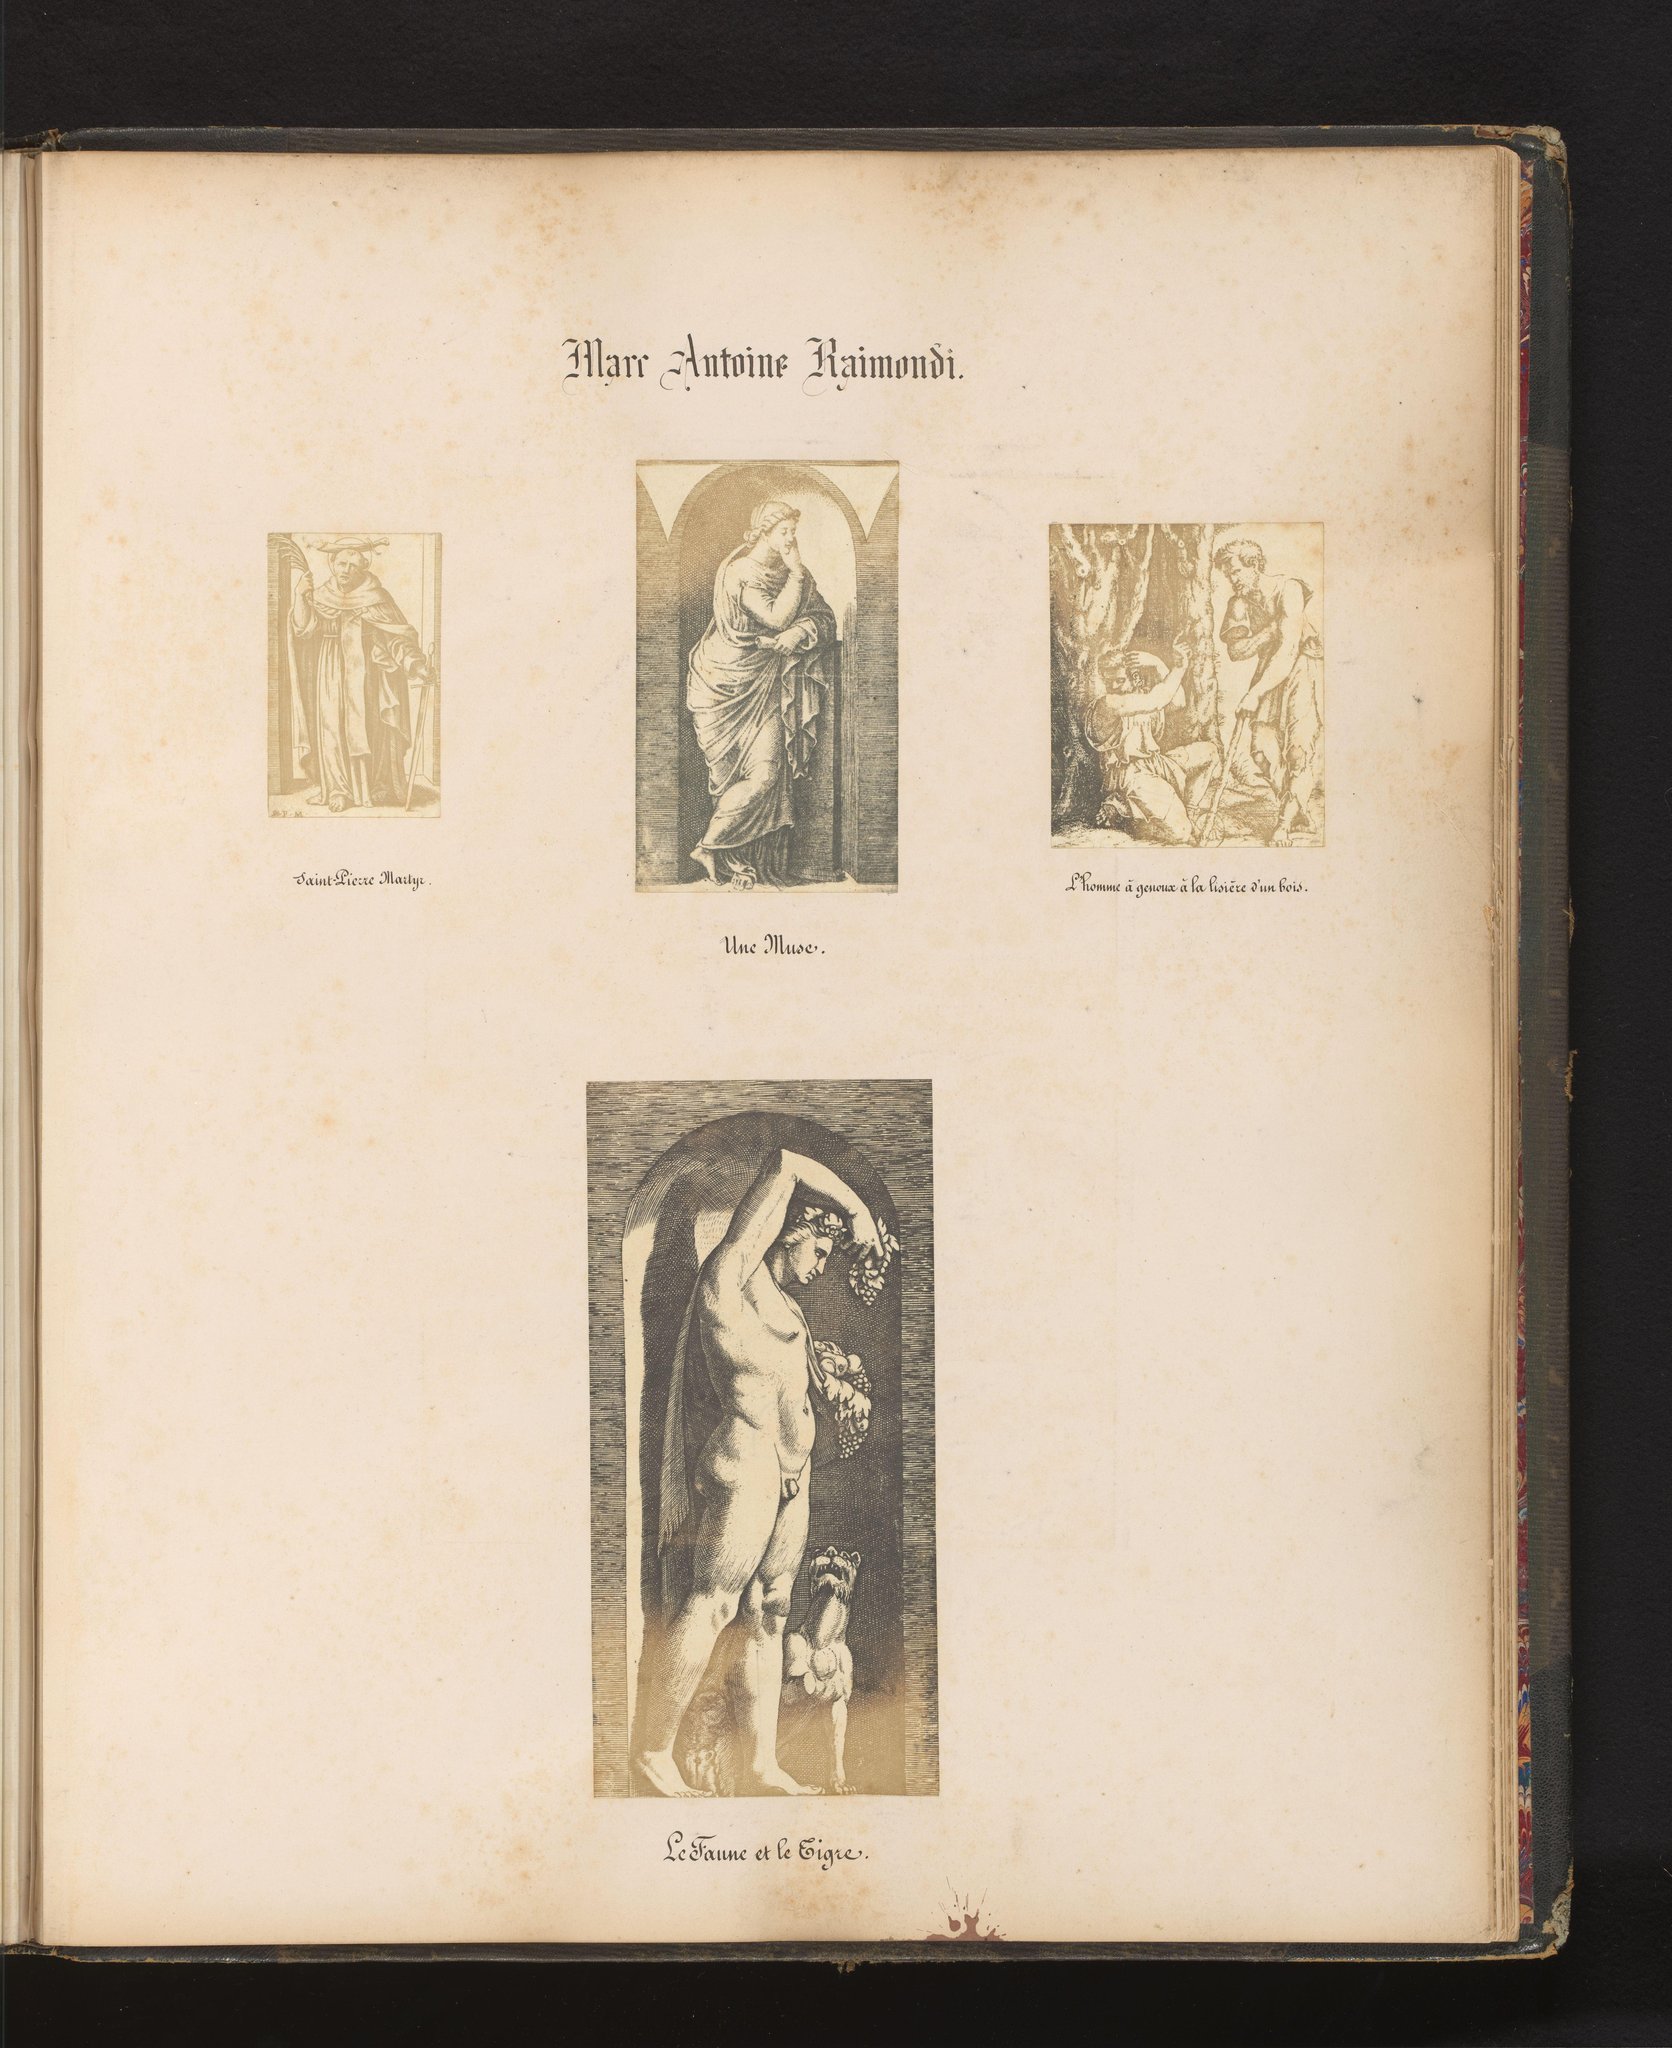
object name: photograph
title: Fotoreproductie van een gravure van een faun en een tijger door Marcantonio Raimondi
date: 1848-1853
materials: photographic support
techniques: salted paper print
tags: beasts of prey, predatory animals: tiger, satyrs, fauns, sileni